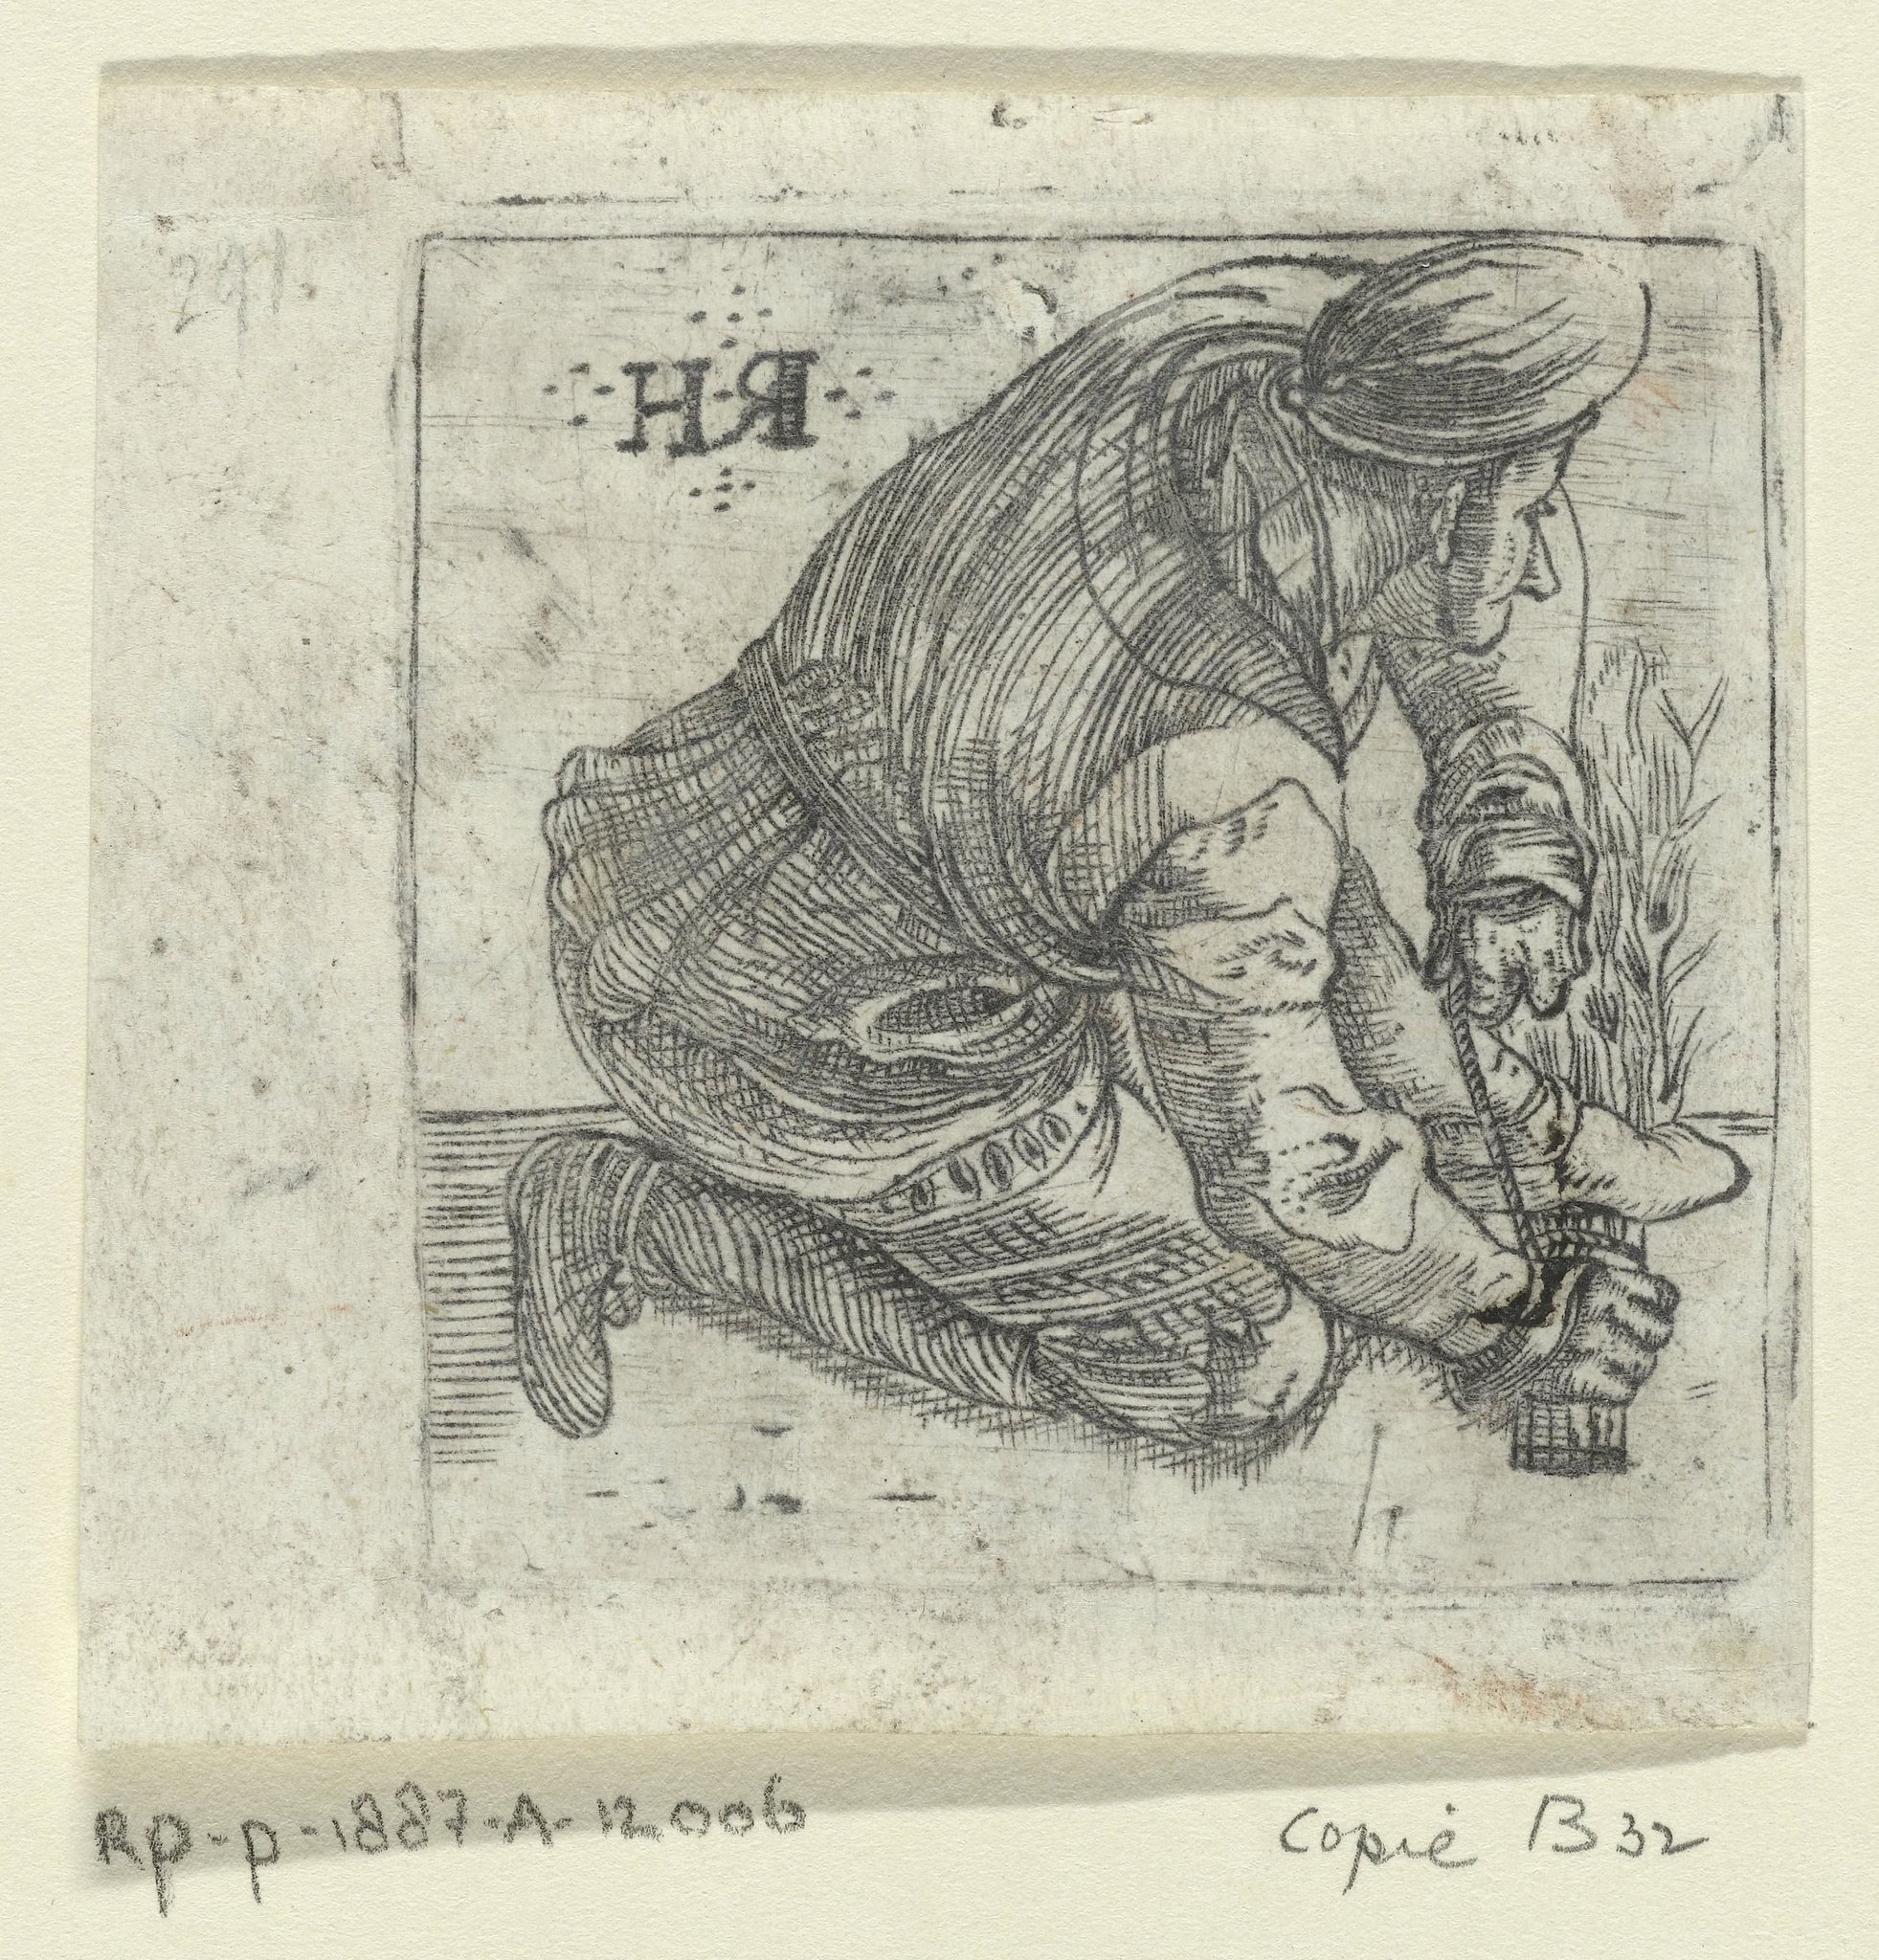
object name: print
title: Geseling van Christus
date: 1597-1667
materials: paper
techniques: engraving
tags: flagellation by soldiers, christ usually tied to a column (matthew 27:26; mark 15:15; john 19:1)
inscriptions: collector's mark: Lugt 2228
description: Een man bindt een bos takken bijeen. Fragment uit een voorstelling van de geseling van Christus.